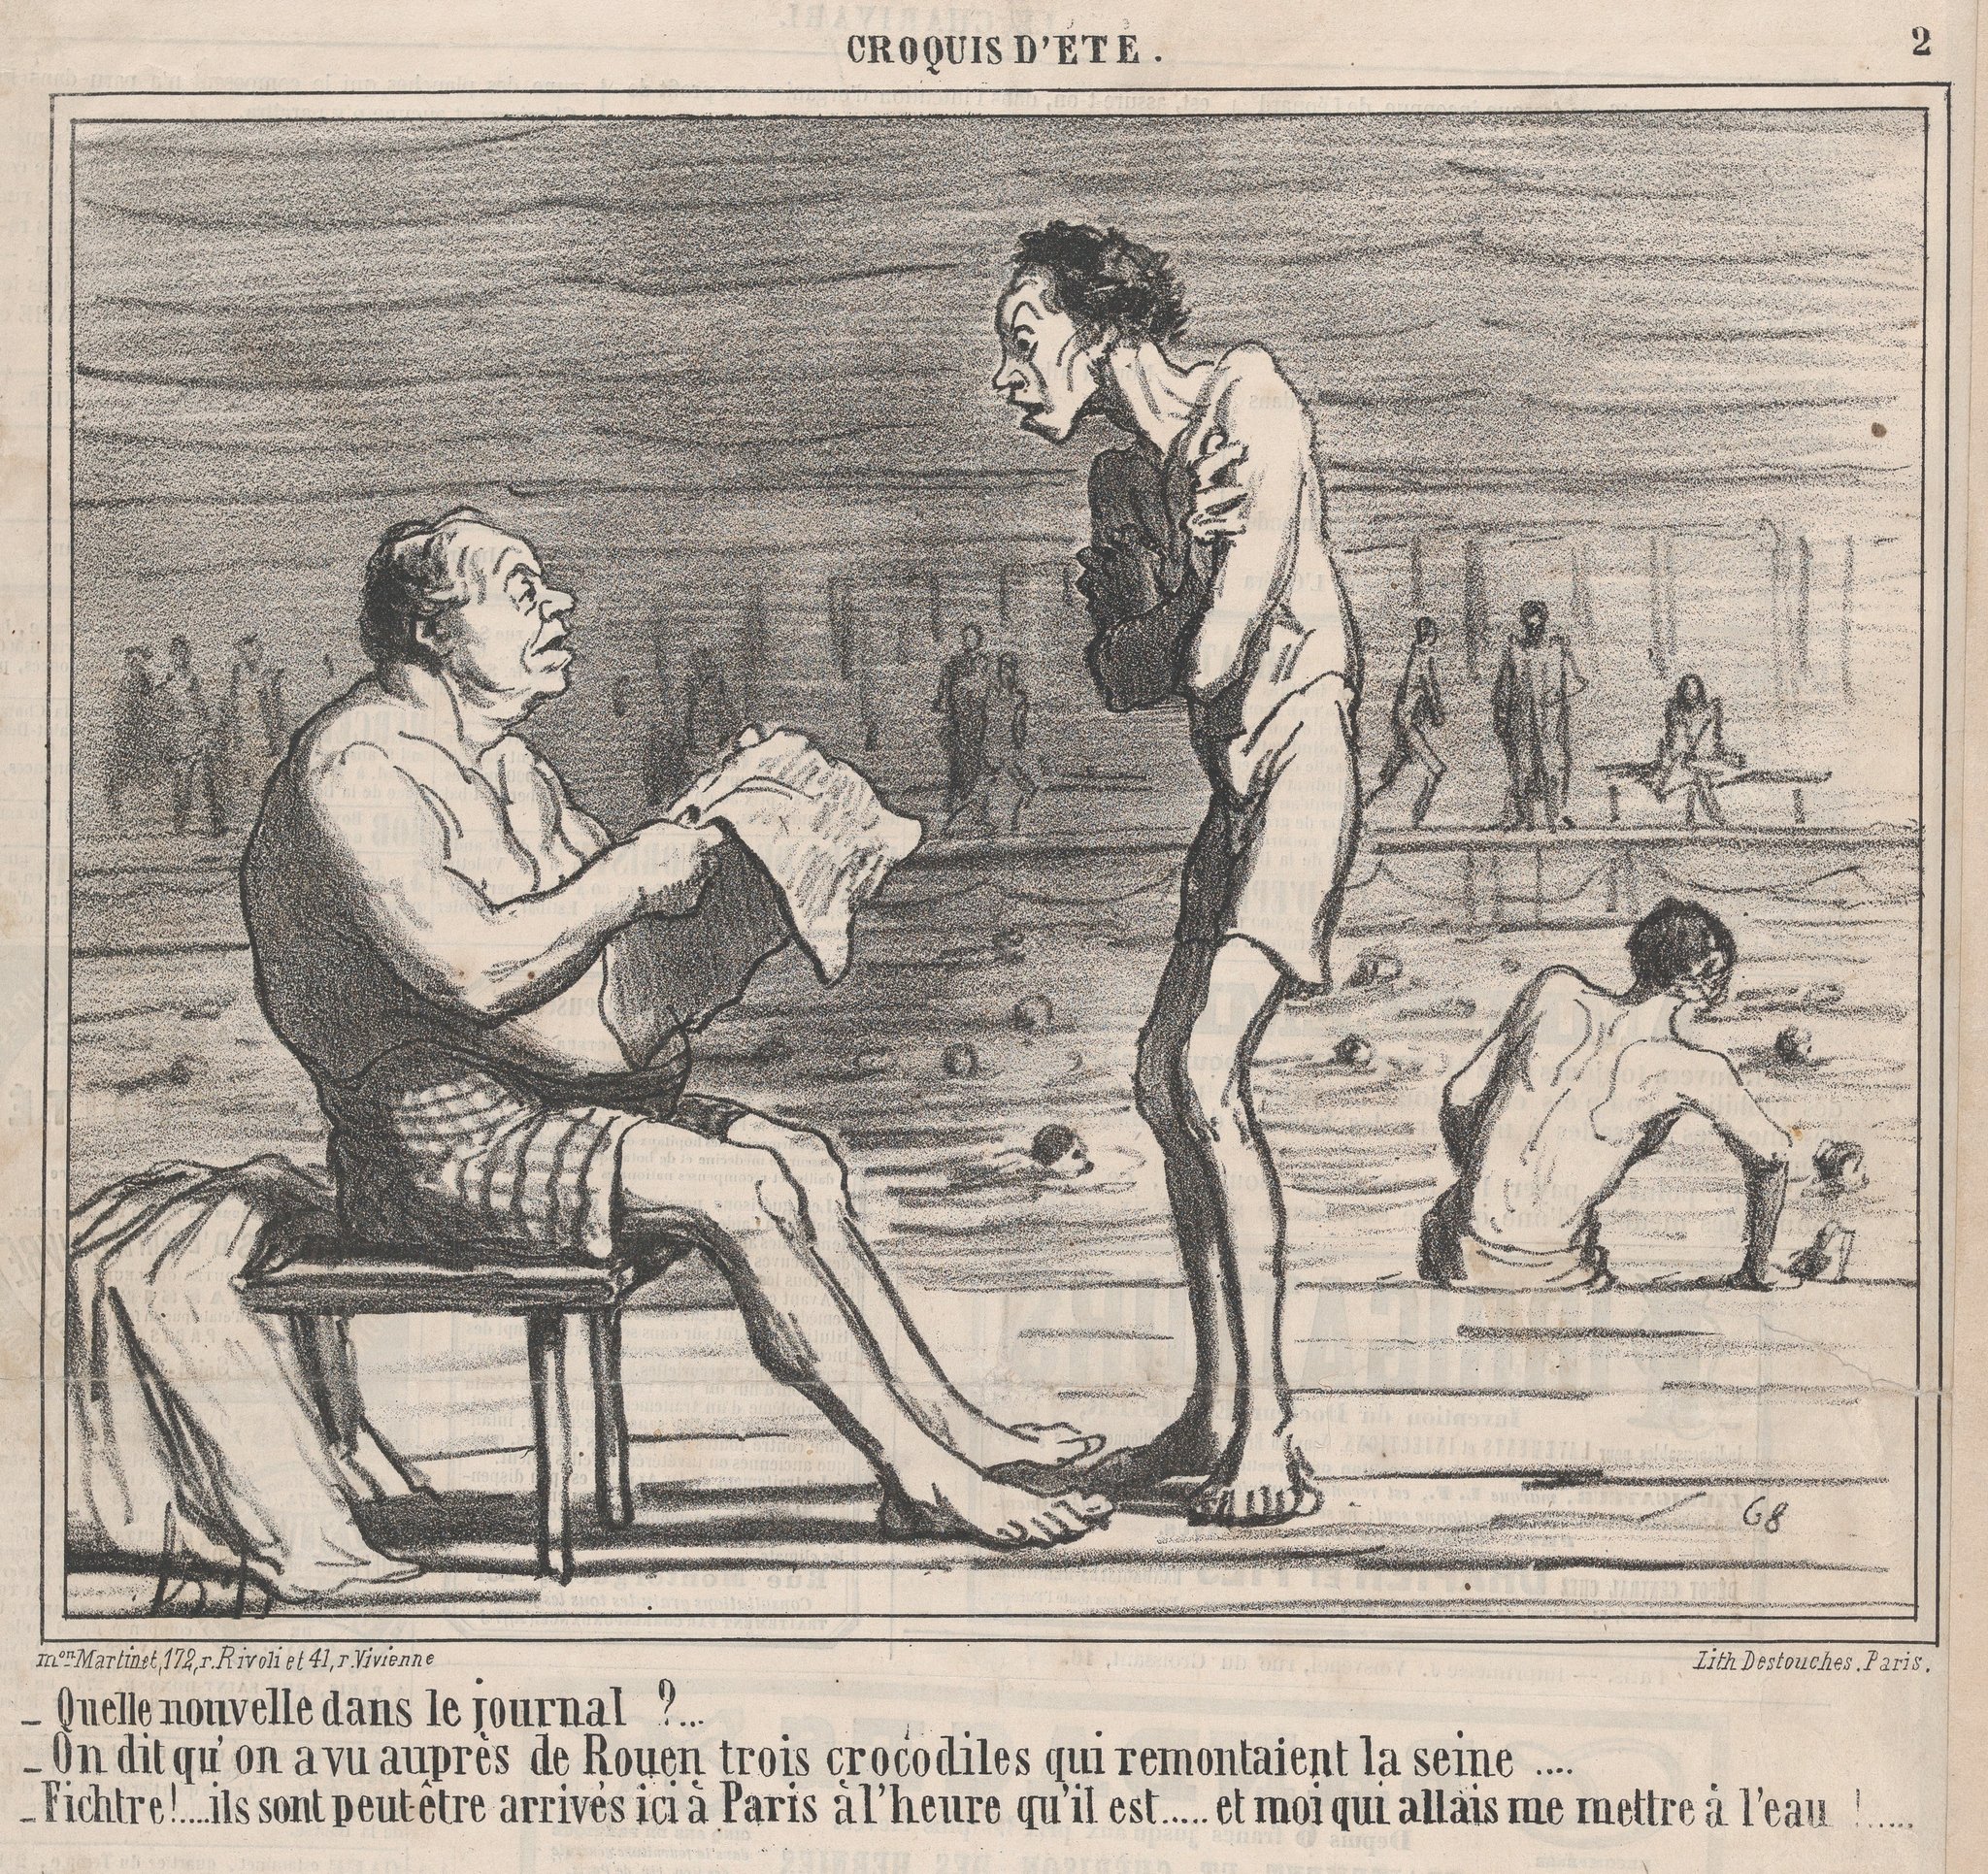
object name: print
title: Quelle nouvelle dans le journal?...., from Croquis d'Été, published in Le Charivari, August 5, 1859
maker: honoré daumier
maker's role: artist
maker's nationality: french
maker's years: 1808-1879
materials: paper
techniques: lithograph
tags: satire,men